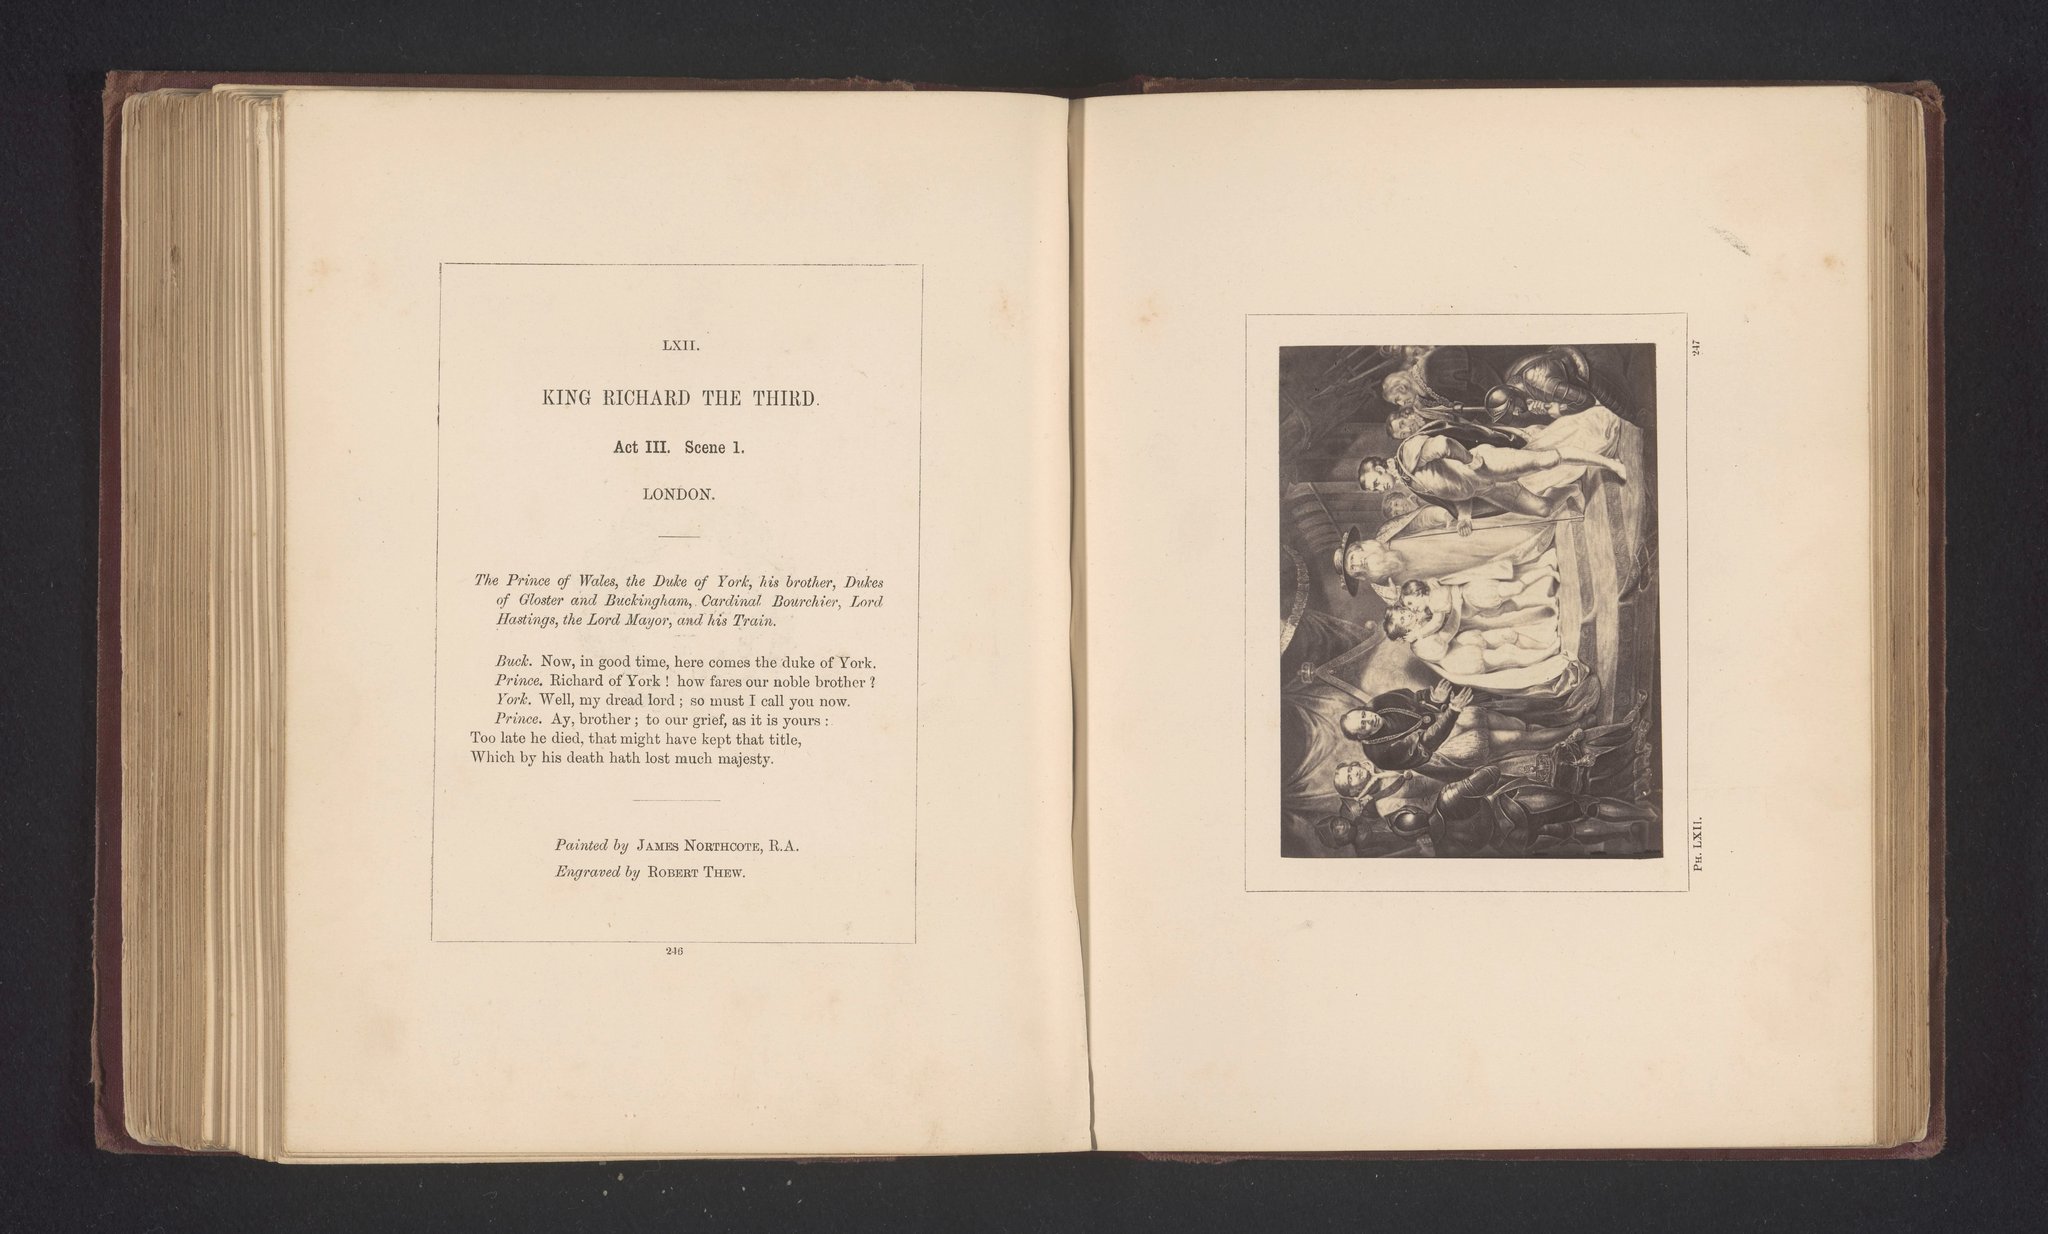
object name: page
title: Fotoreproductie van een prent naar een schilderij door James Northcote, voorstellend een scene uit Richard III door William Shakespeare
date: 1854-1867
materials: photographic support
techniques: albumen print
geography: london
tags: specific works of literature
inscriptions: number: ‘Ph. LXII. 247’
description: Te zien is akte III, scene 1 met een gezelschap in een paleis in Londen.